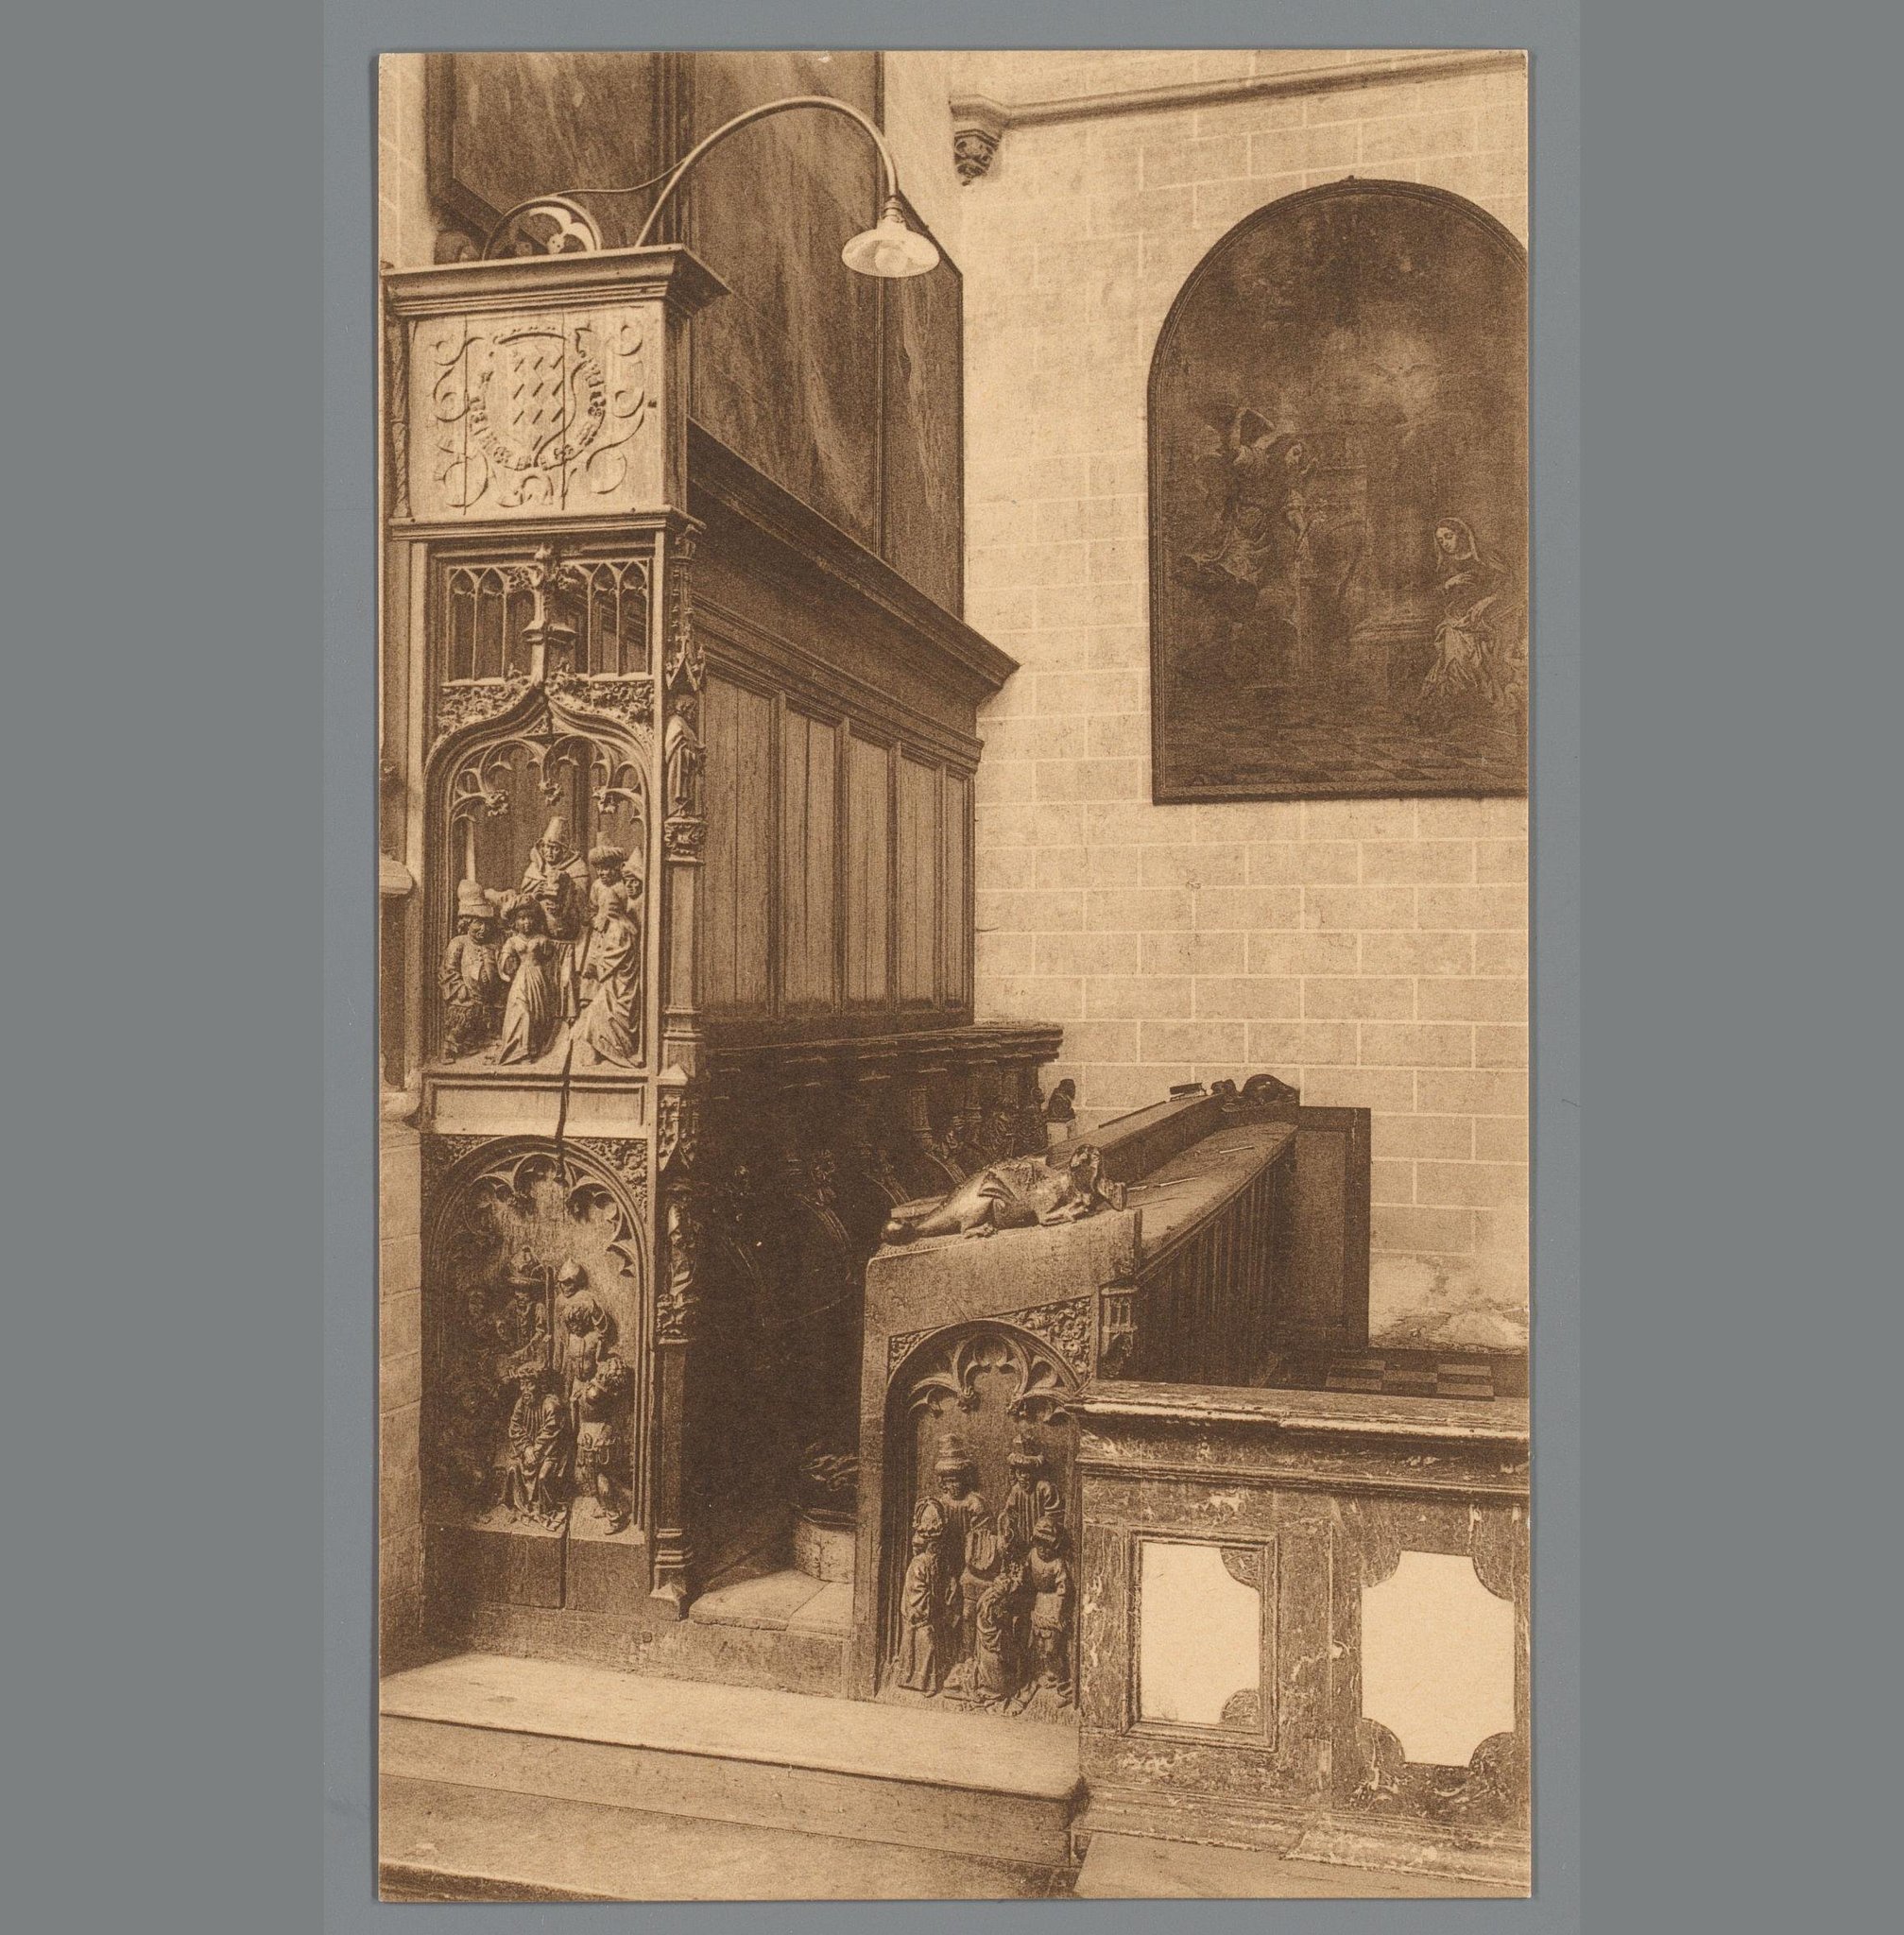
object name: ansichtkaart, prentbriefkaart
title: Hoogstraten. Gestoelte der oude kerk. Gotische stijl der 15de eeuw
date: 1907-1913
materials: cardboard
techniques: photograph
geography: brussels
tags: bench, interior of church